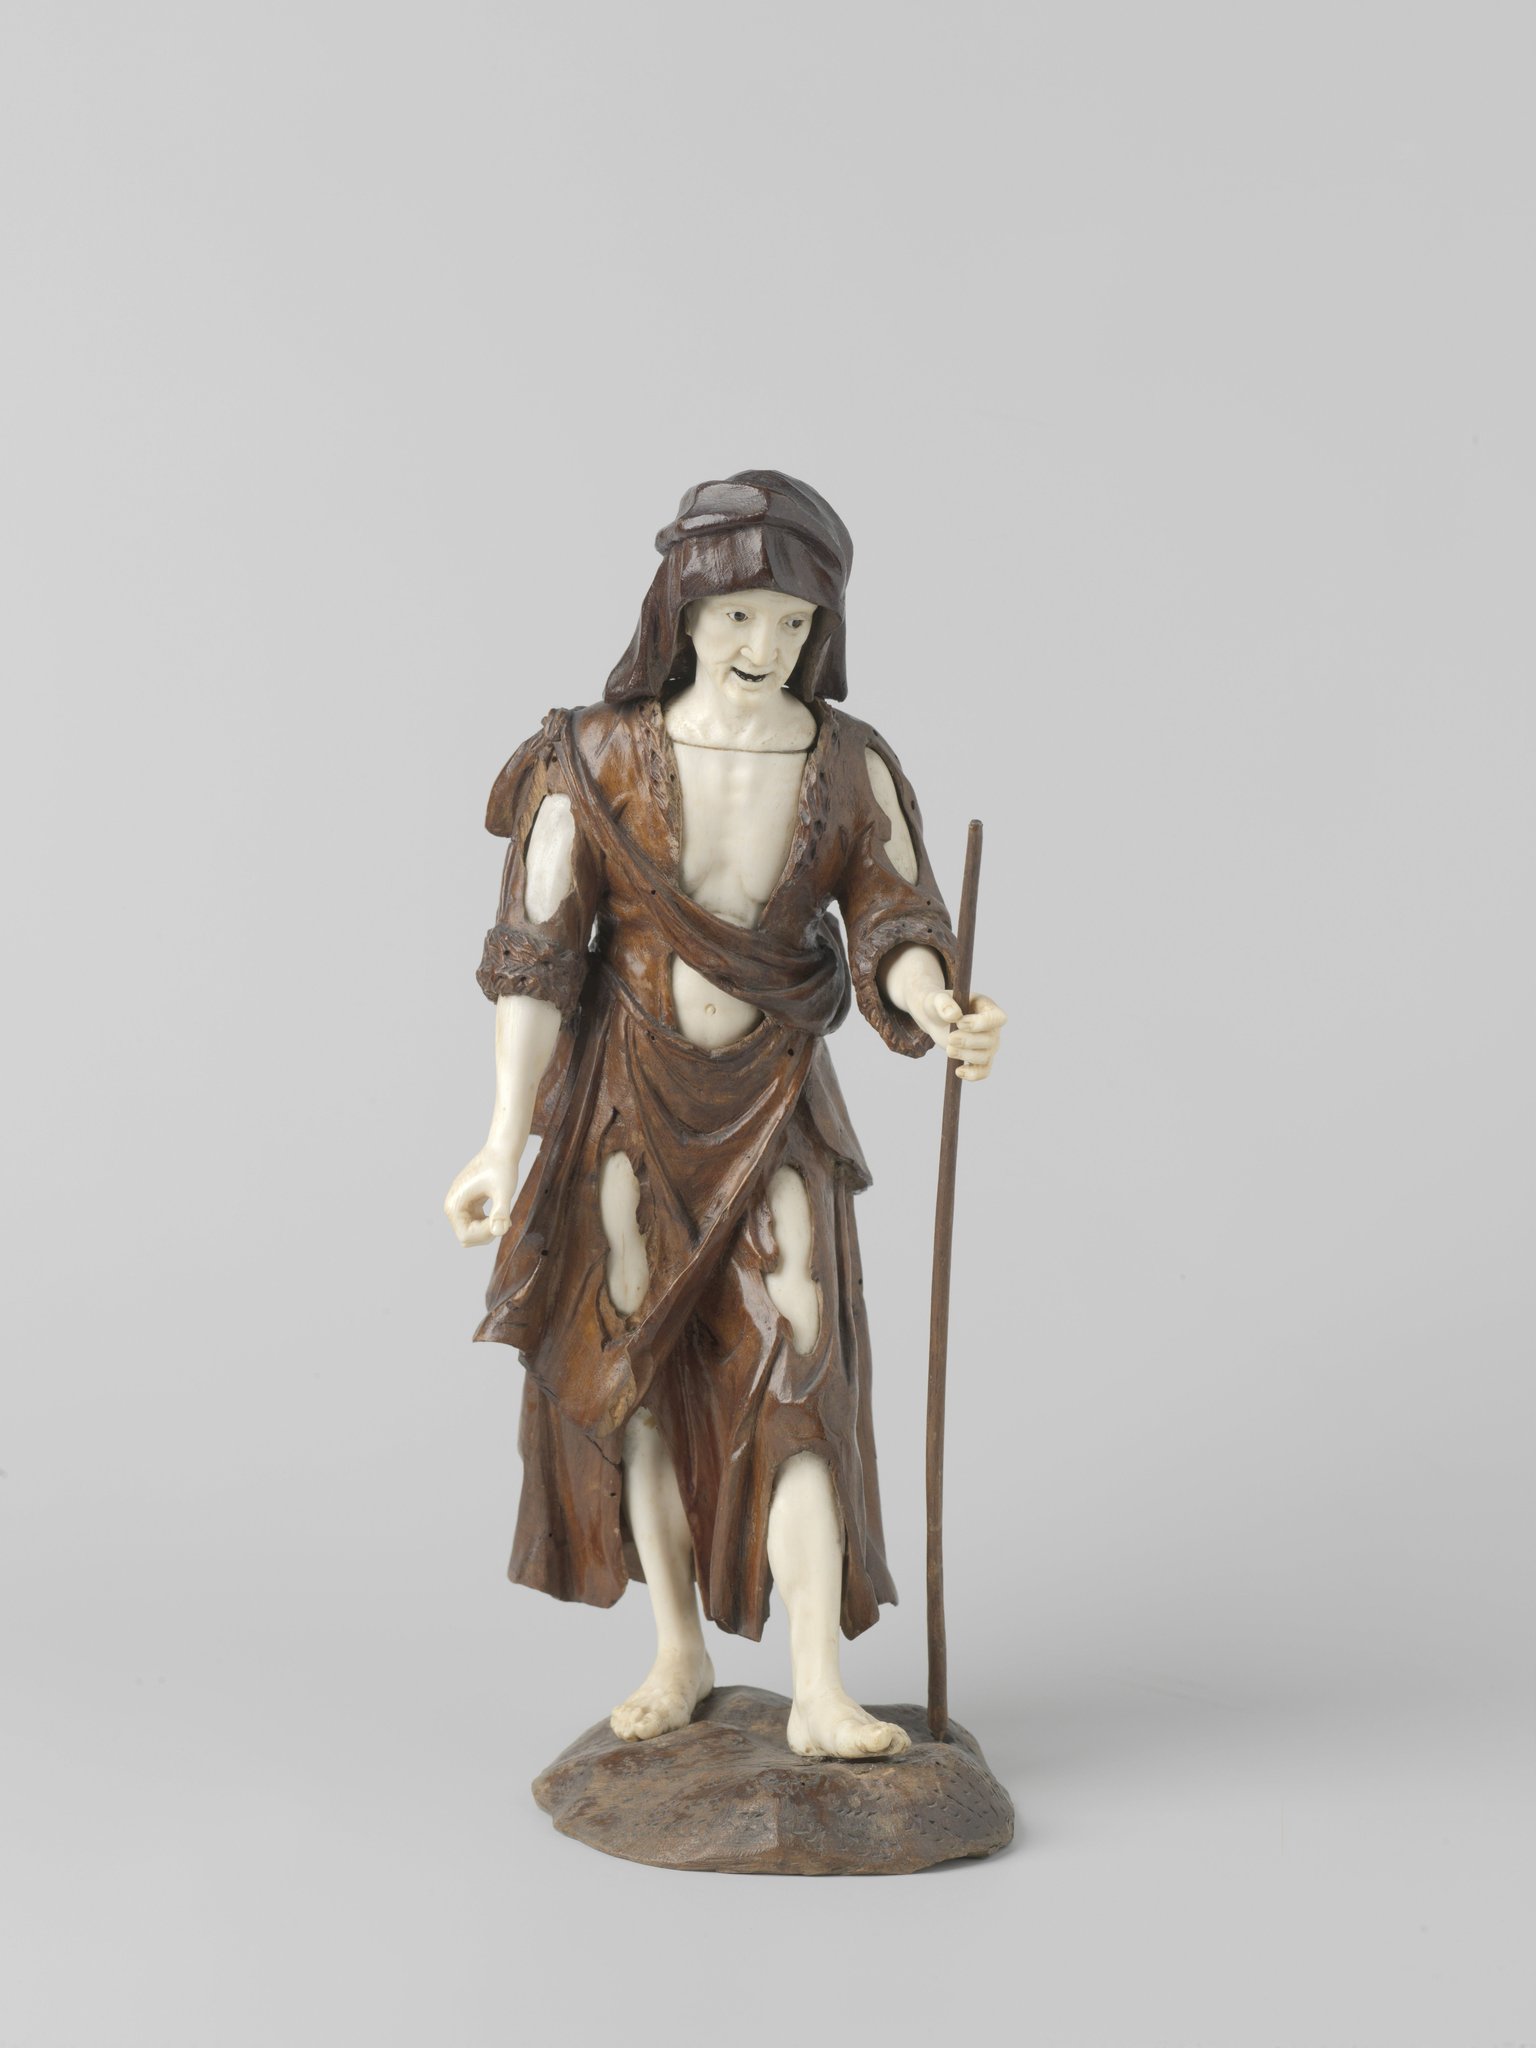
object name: sculpture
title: Bedelende figuur met twee stokken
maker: simon troger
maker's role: sculptor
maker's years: 1693-1768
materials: ivory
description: Bedelaar met in elke hand een wandelstok. Op de rug draagt hij kruiken en potten.